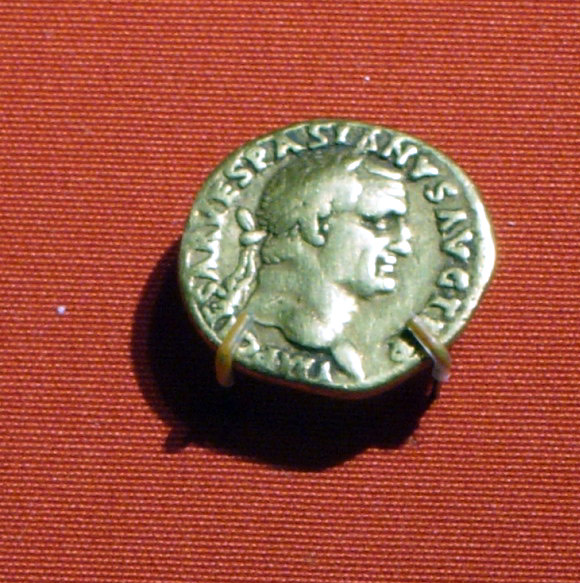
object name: coin, aureus of vespasian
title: Aureus of Vespasian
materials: gold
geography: gaul